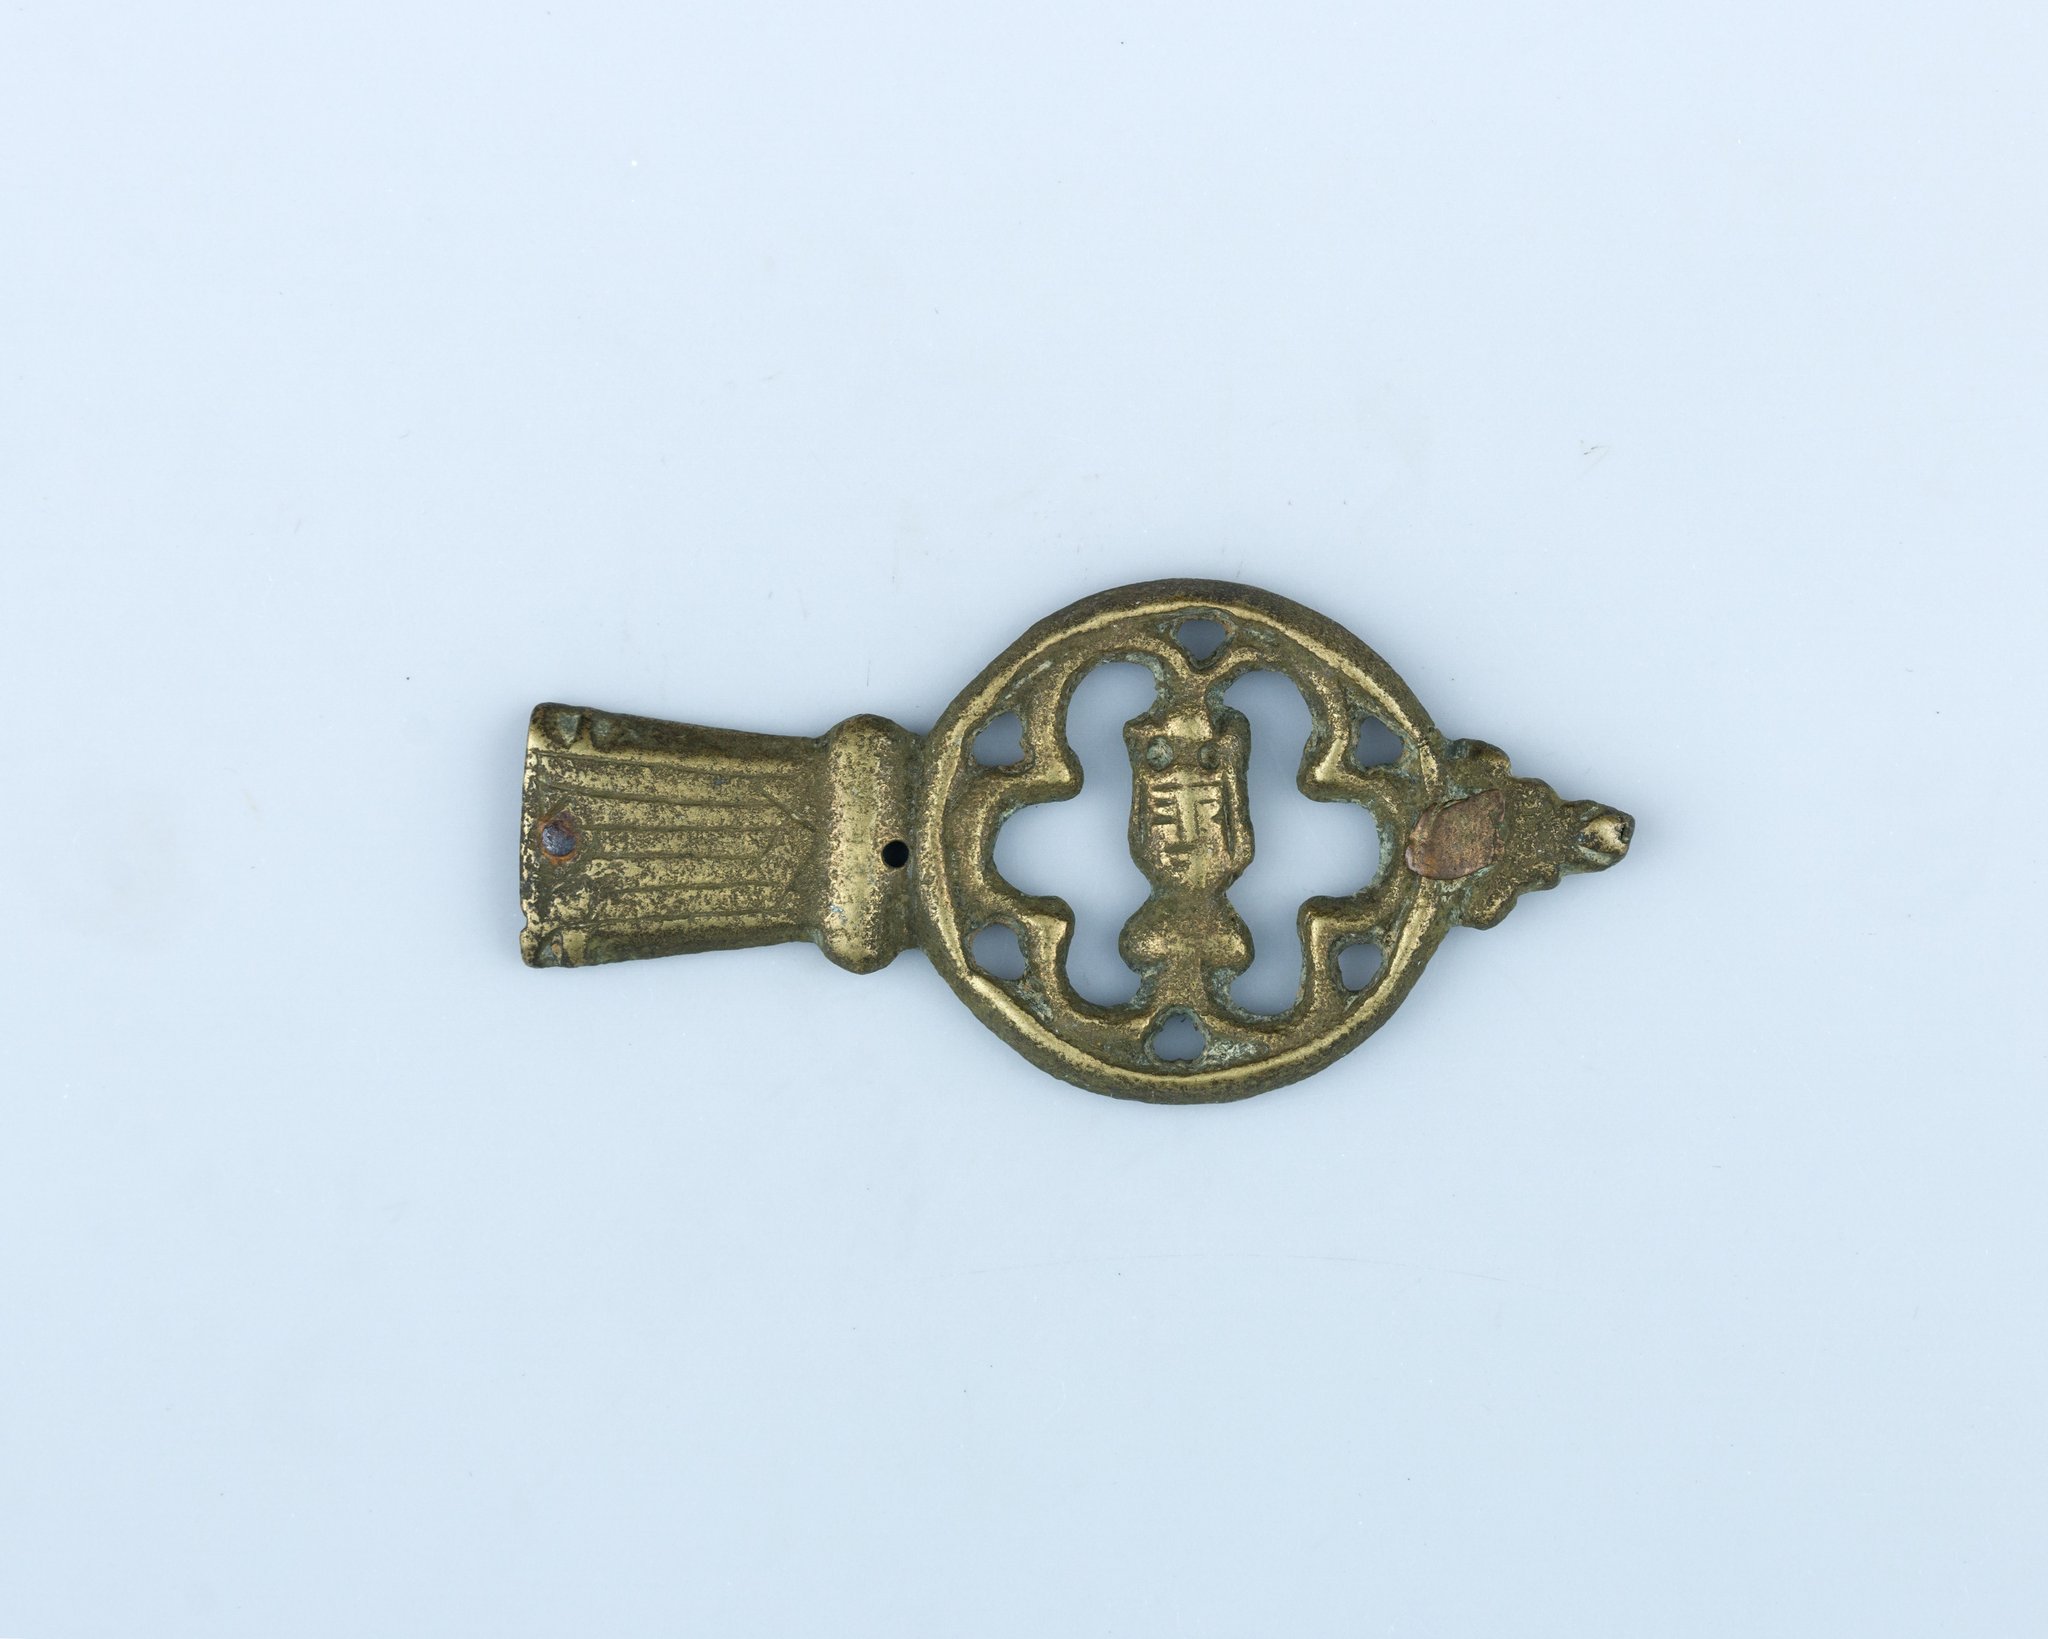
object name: pendant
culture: european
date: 1401-1700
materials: brass